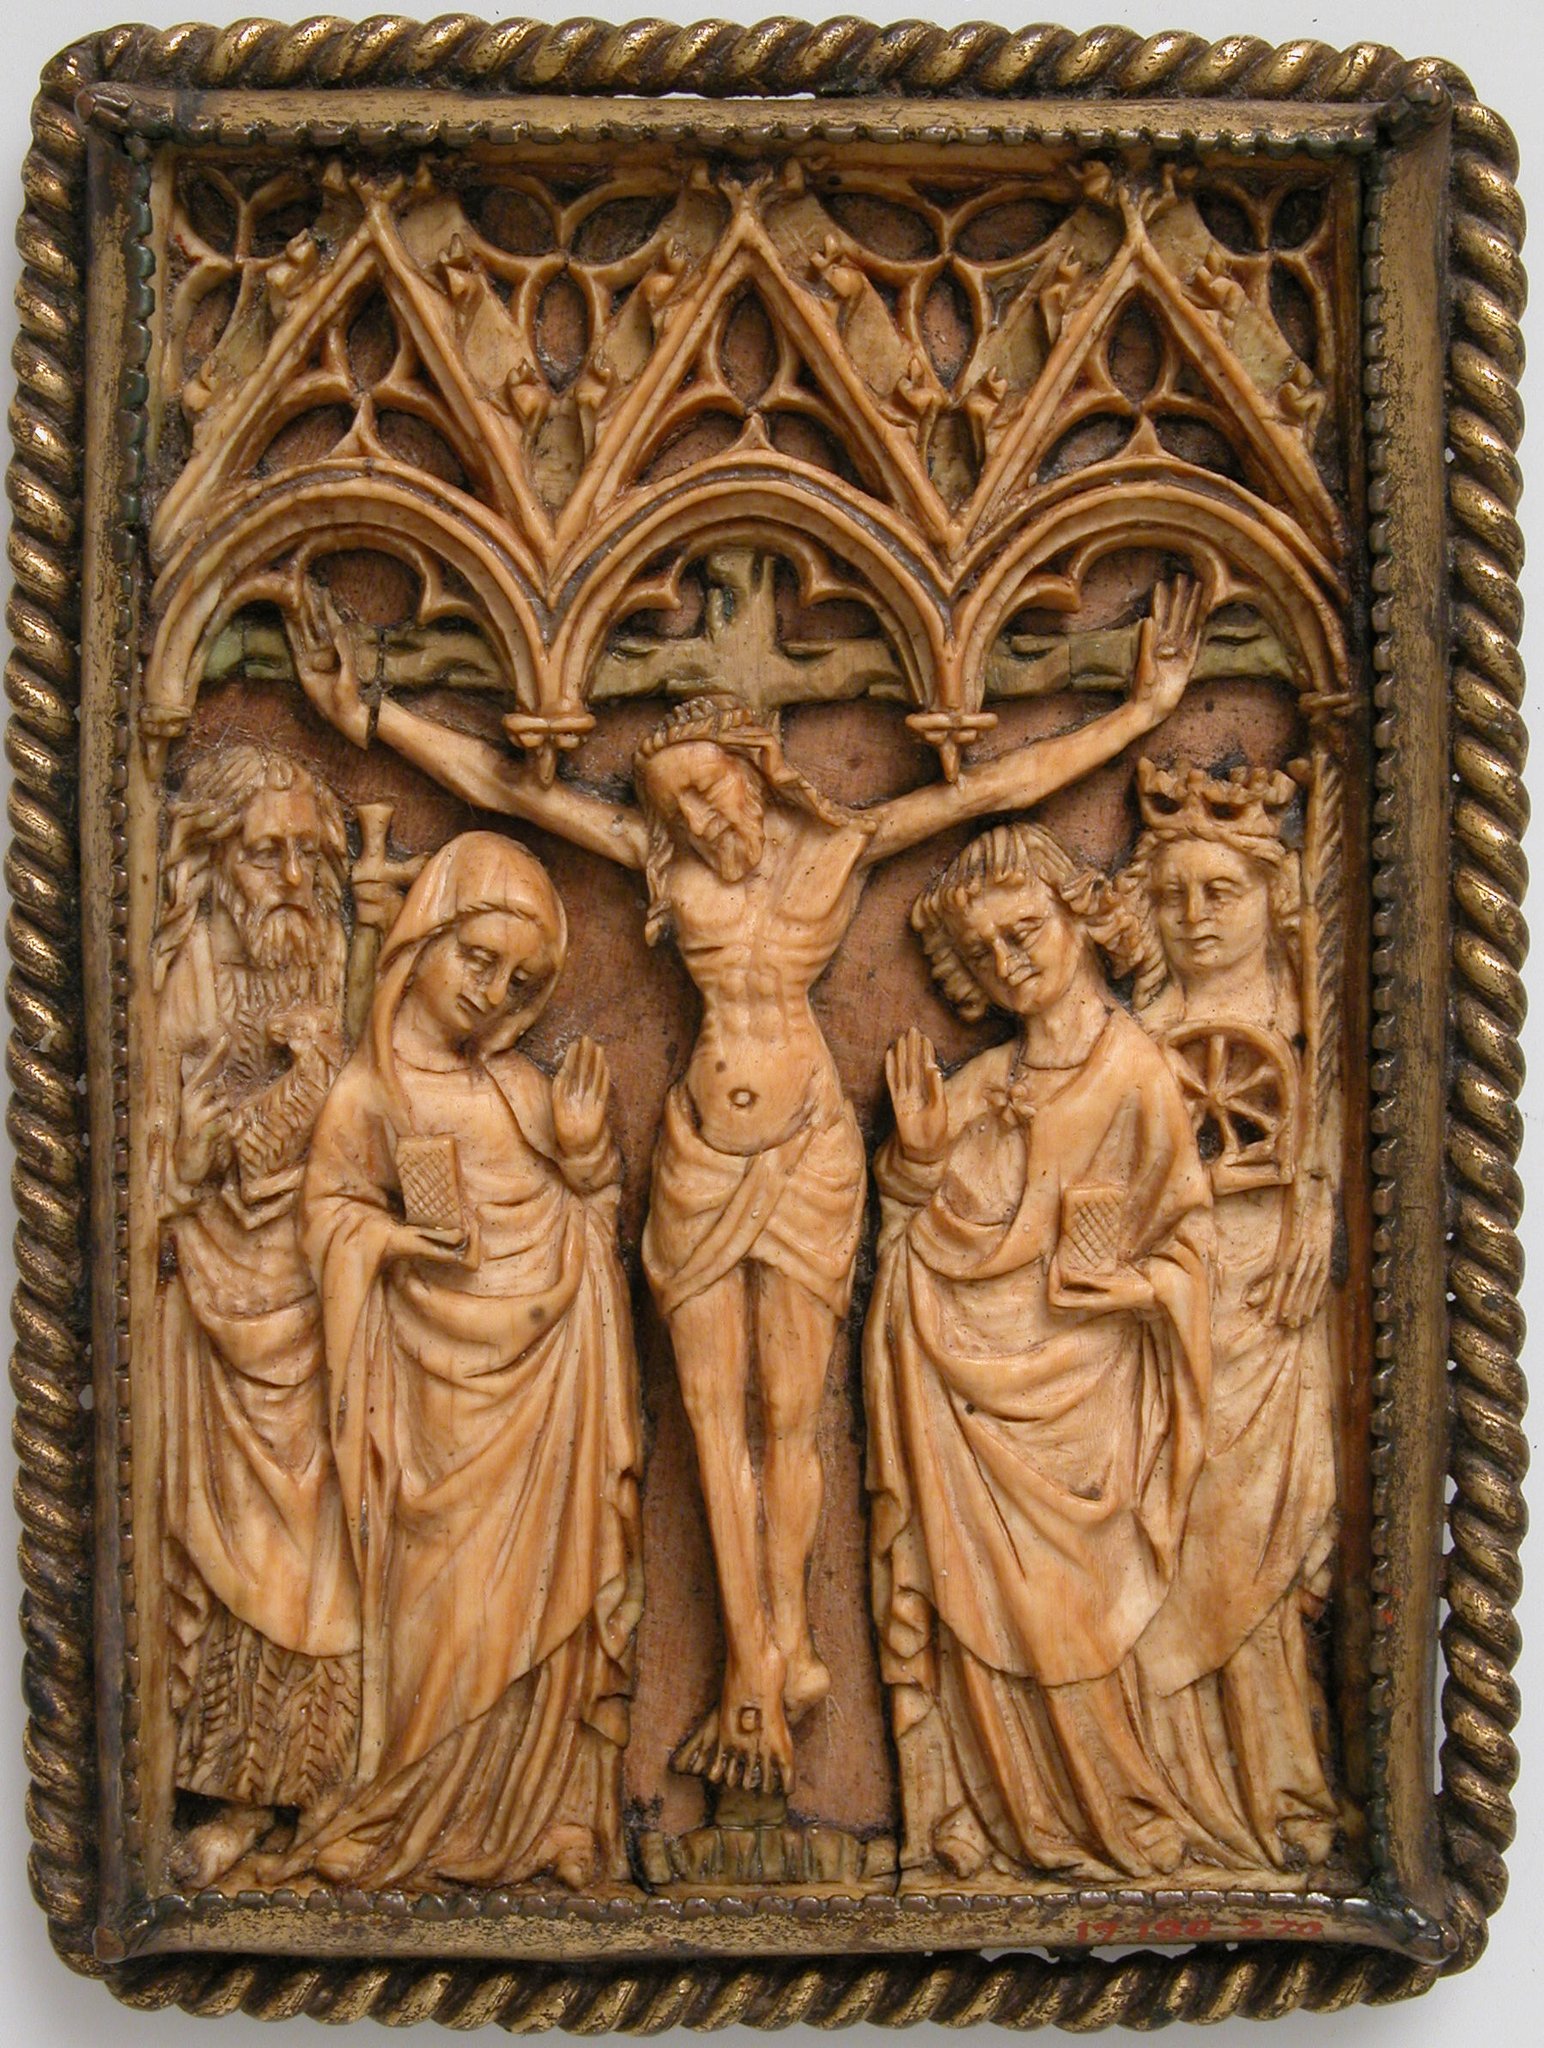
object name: plaque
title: Plaque with the Crucifixion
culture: dutch or french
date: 1301-1400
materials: gilt copper, ivory, wood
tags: men,women,virgin mary,cross